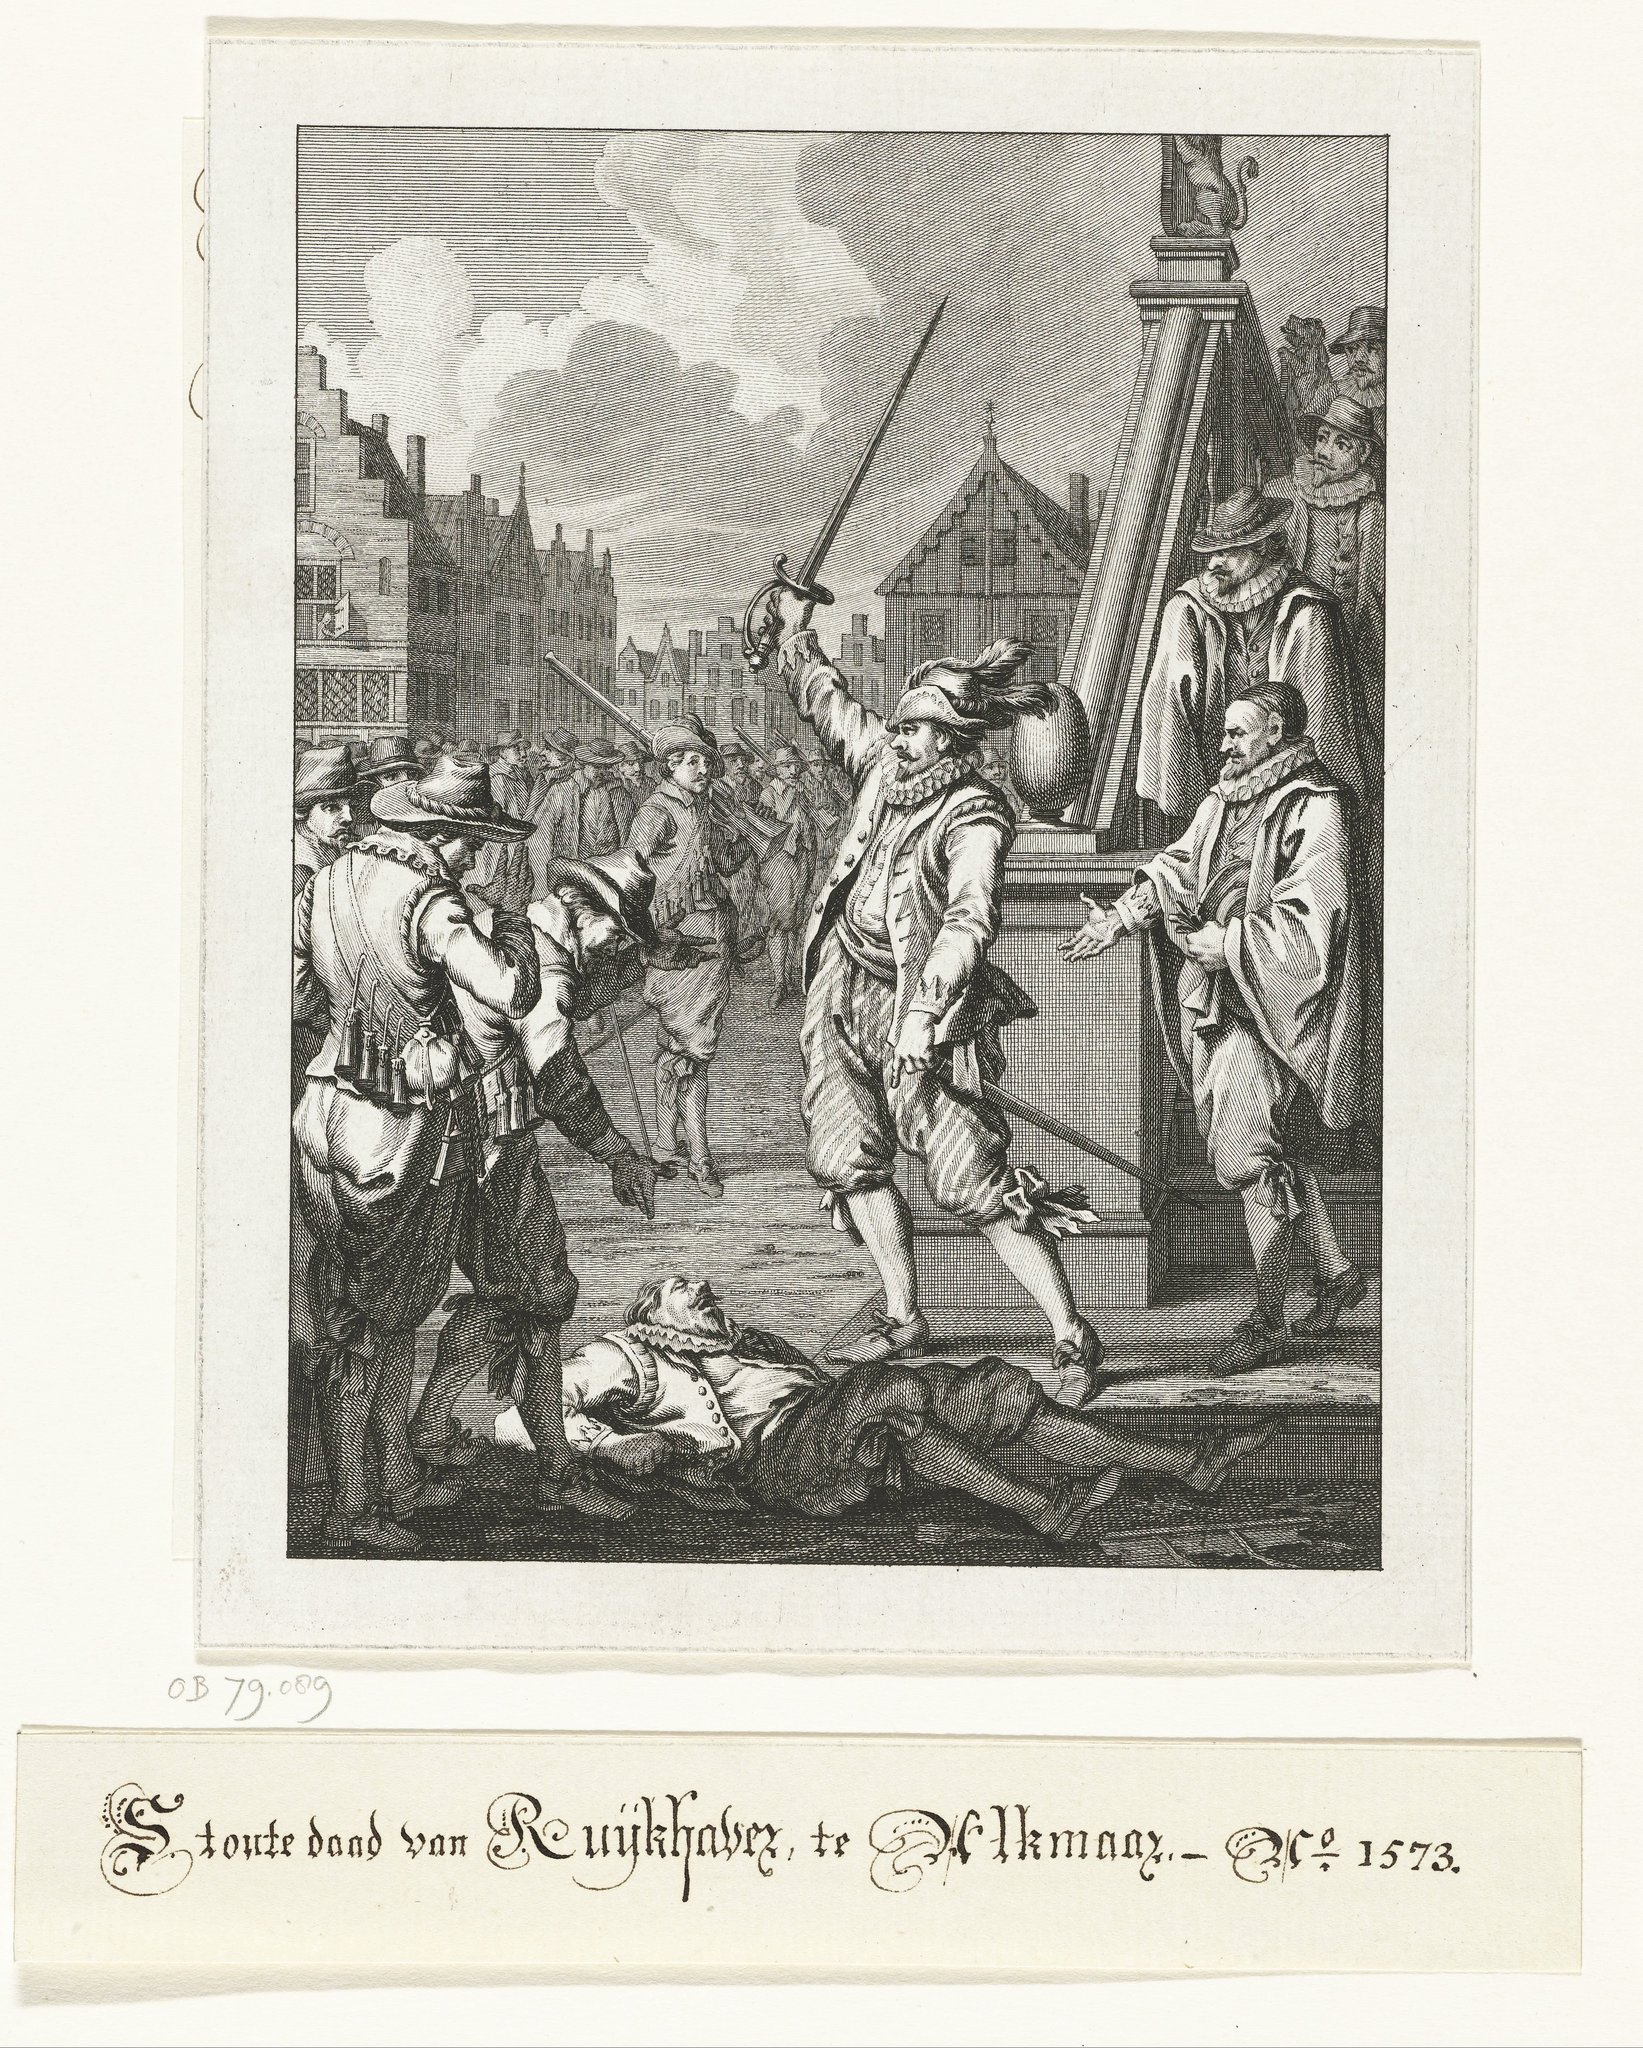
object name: history print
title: Ruychaver bij het lijk van een spaansgezinde raadsman te Alkmaar, 1573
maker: theodoor koning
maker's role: print maker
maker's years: 1748-1829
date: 1780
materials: paper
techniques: etching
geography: northern netherlands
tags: amsterdam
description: Illustratie voor: J. Nomsz, Willem de eerste, of de grondlegging der Nederlandsche vryheid. : In vier en twintig zangen, Erven van David Klippink, Amsterdam 1779. Staat vóór de letter. Met de handgeschreven titel in pen in bruin op een apart papiertje.